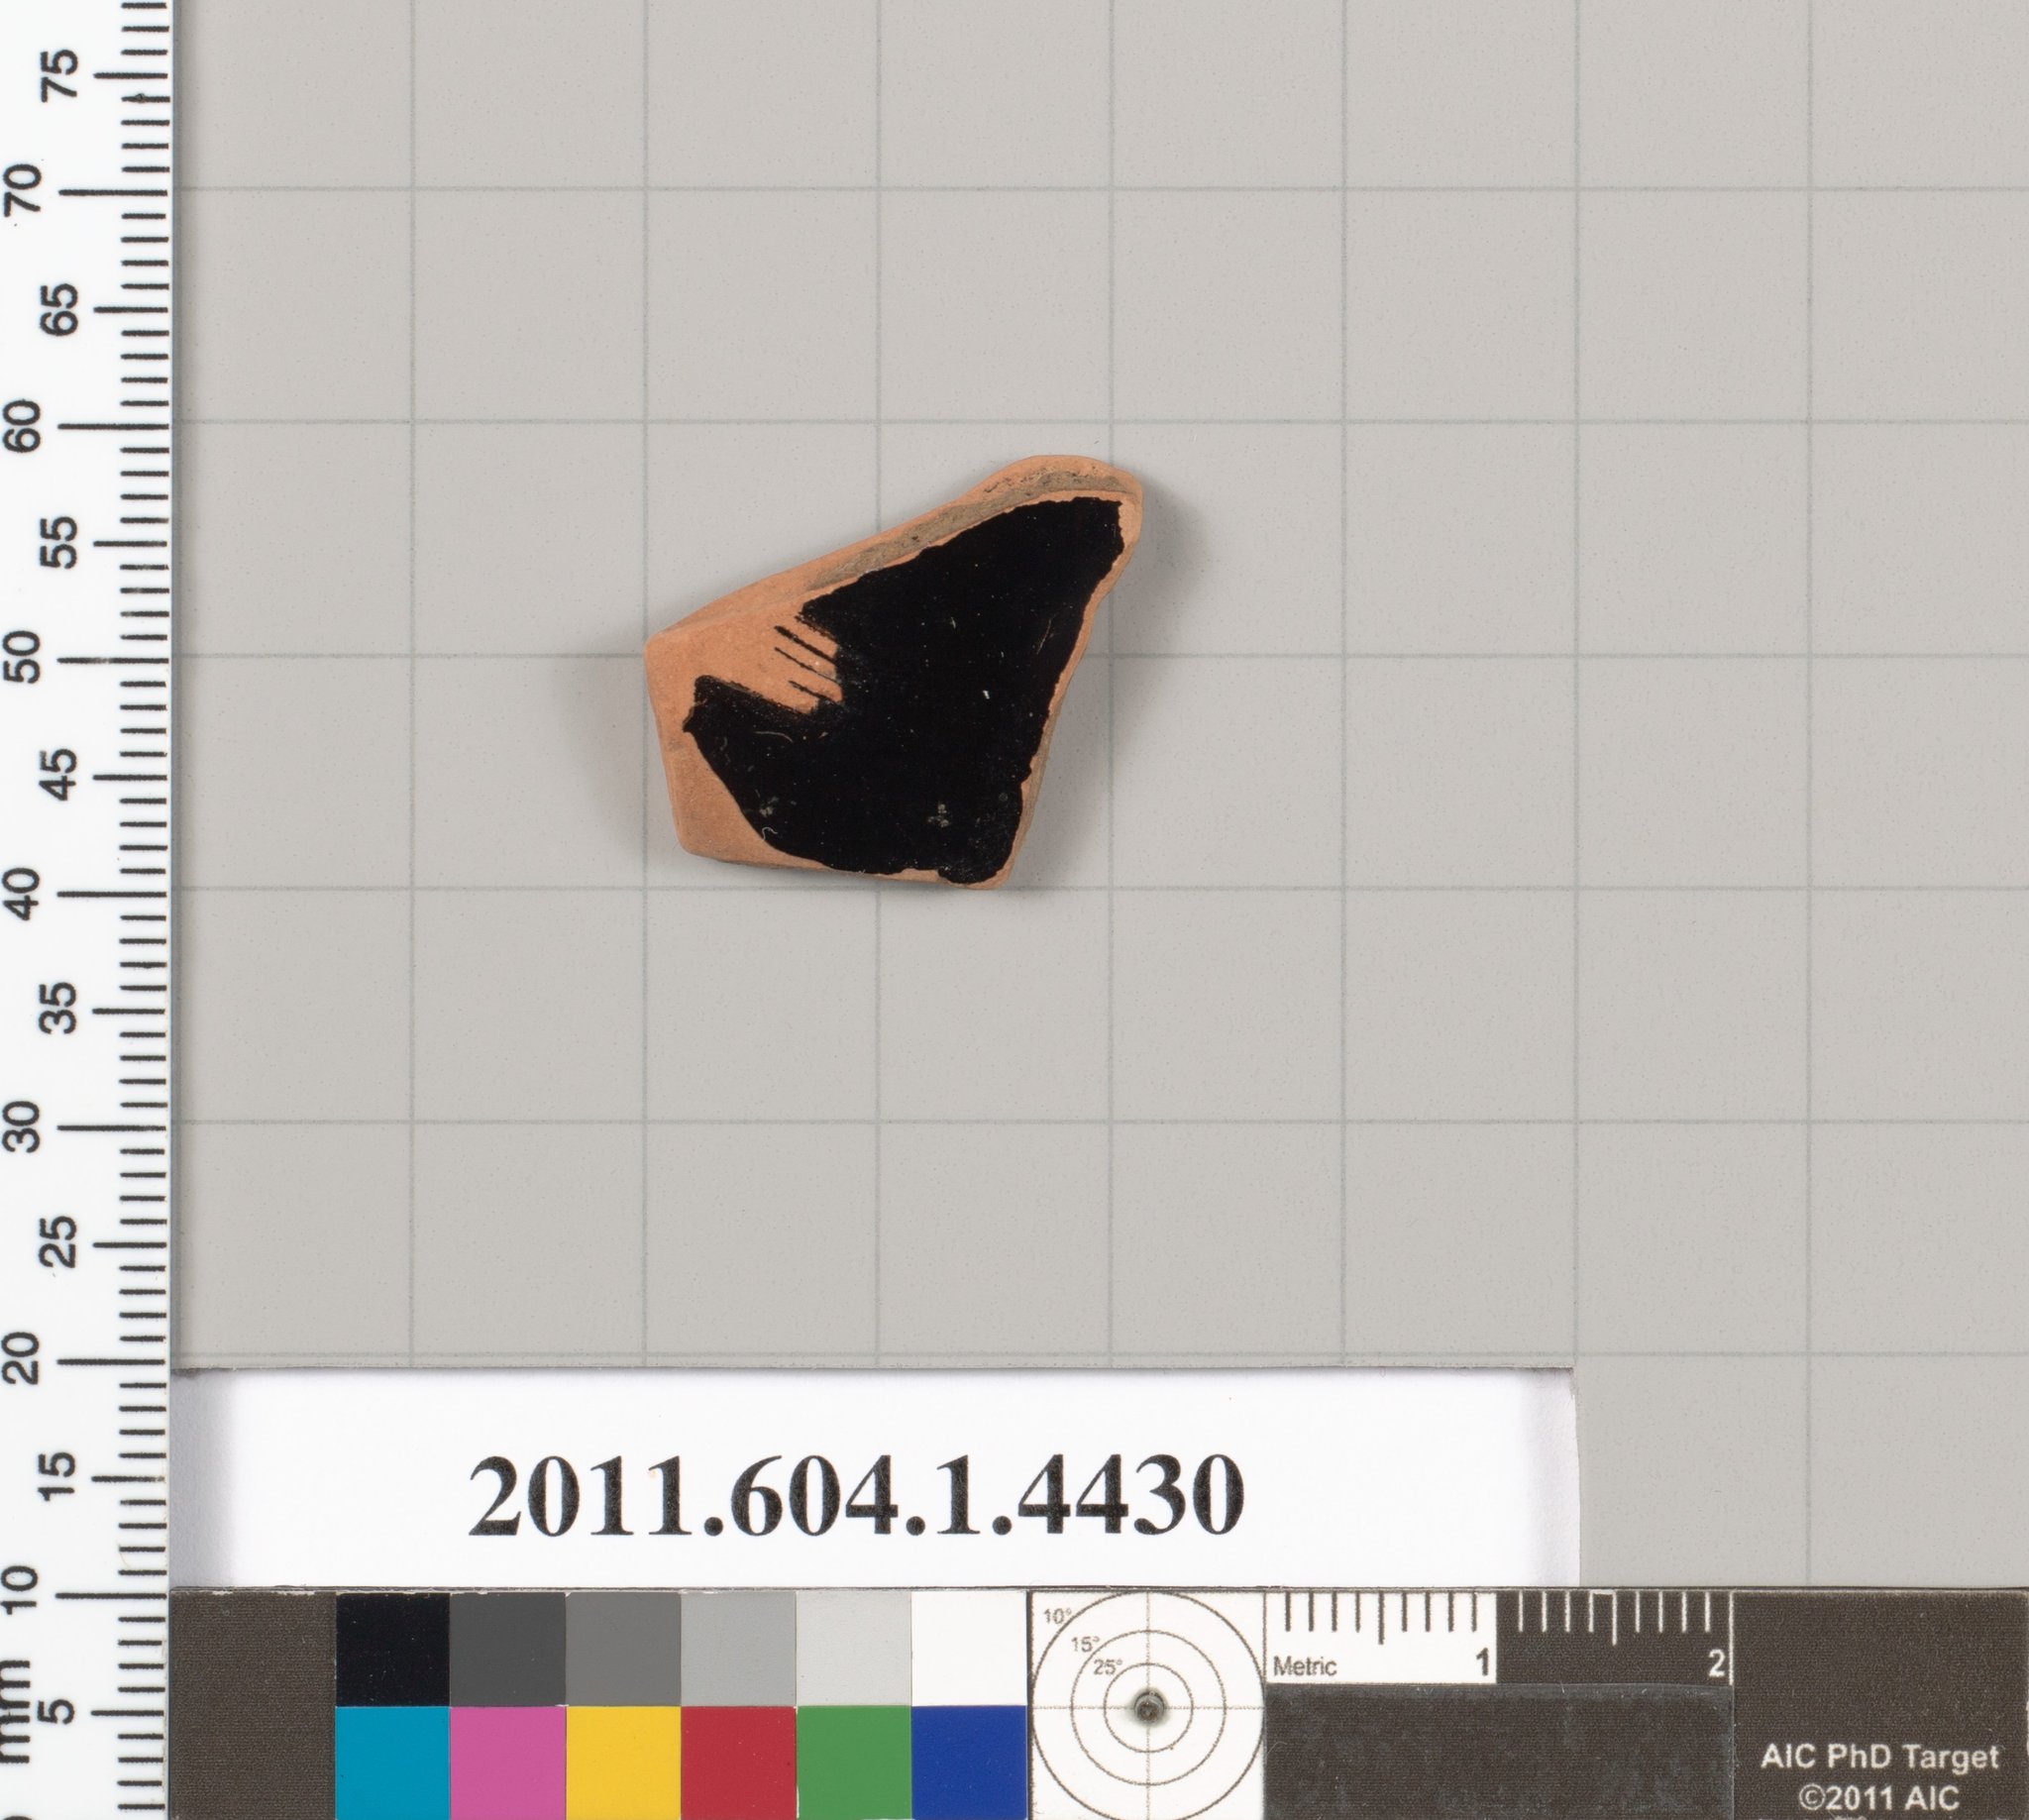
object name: kylix fragment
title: Terracotta fragment of a kylix (drinking cup)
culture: greek, attic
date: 475-451 BCE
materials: terracotta